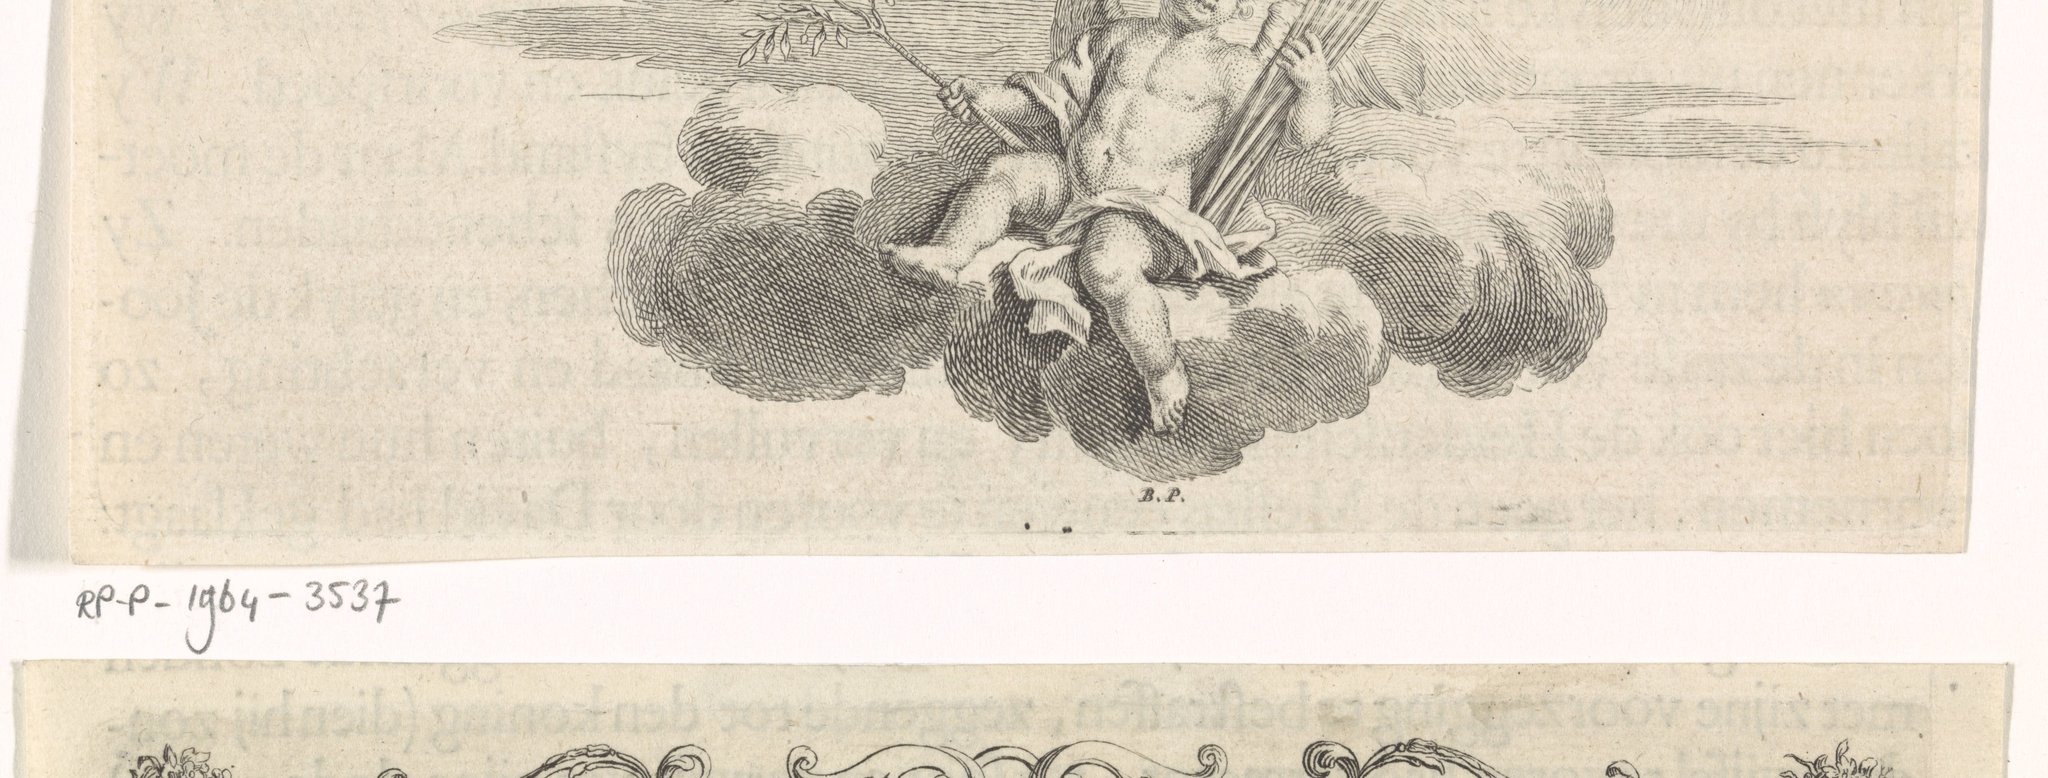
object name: print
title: Engel met de bloeiende staf van Aäron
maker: bernard picart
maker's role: draughtsman, print maker, publisher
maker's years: 1673-1733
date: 1683-1733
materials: paper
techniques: engraving, etching, letterpress printing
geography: amsterdam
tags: the flowering rod (numbers 17)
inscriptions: collector's mark: Lugt 2228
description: Prent oorspronkelijk bedoeld voor: Figures de la Bible. Amsterdam, Bernard Picart, 1720. Prent ook gebruikt in: Taferelen der voornaamste geschiedenissen van het Oude en Nieuwe Testament (...) door de vermaarde kunstenaars Hoet, Houbraken, en Picart getekent (...) en met beschrijvingen uitgebreid. Den Haag: Pieter de Hondt, 1728. Mogelijk ook gebruikt in andere bijbels.